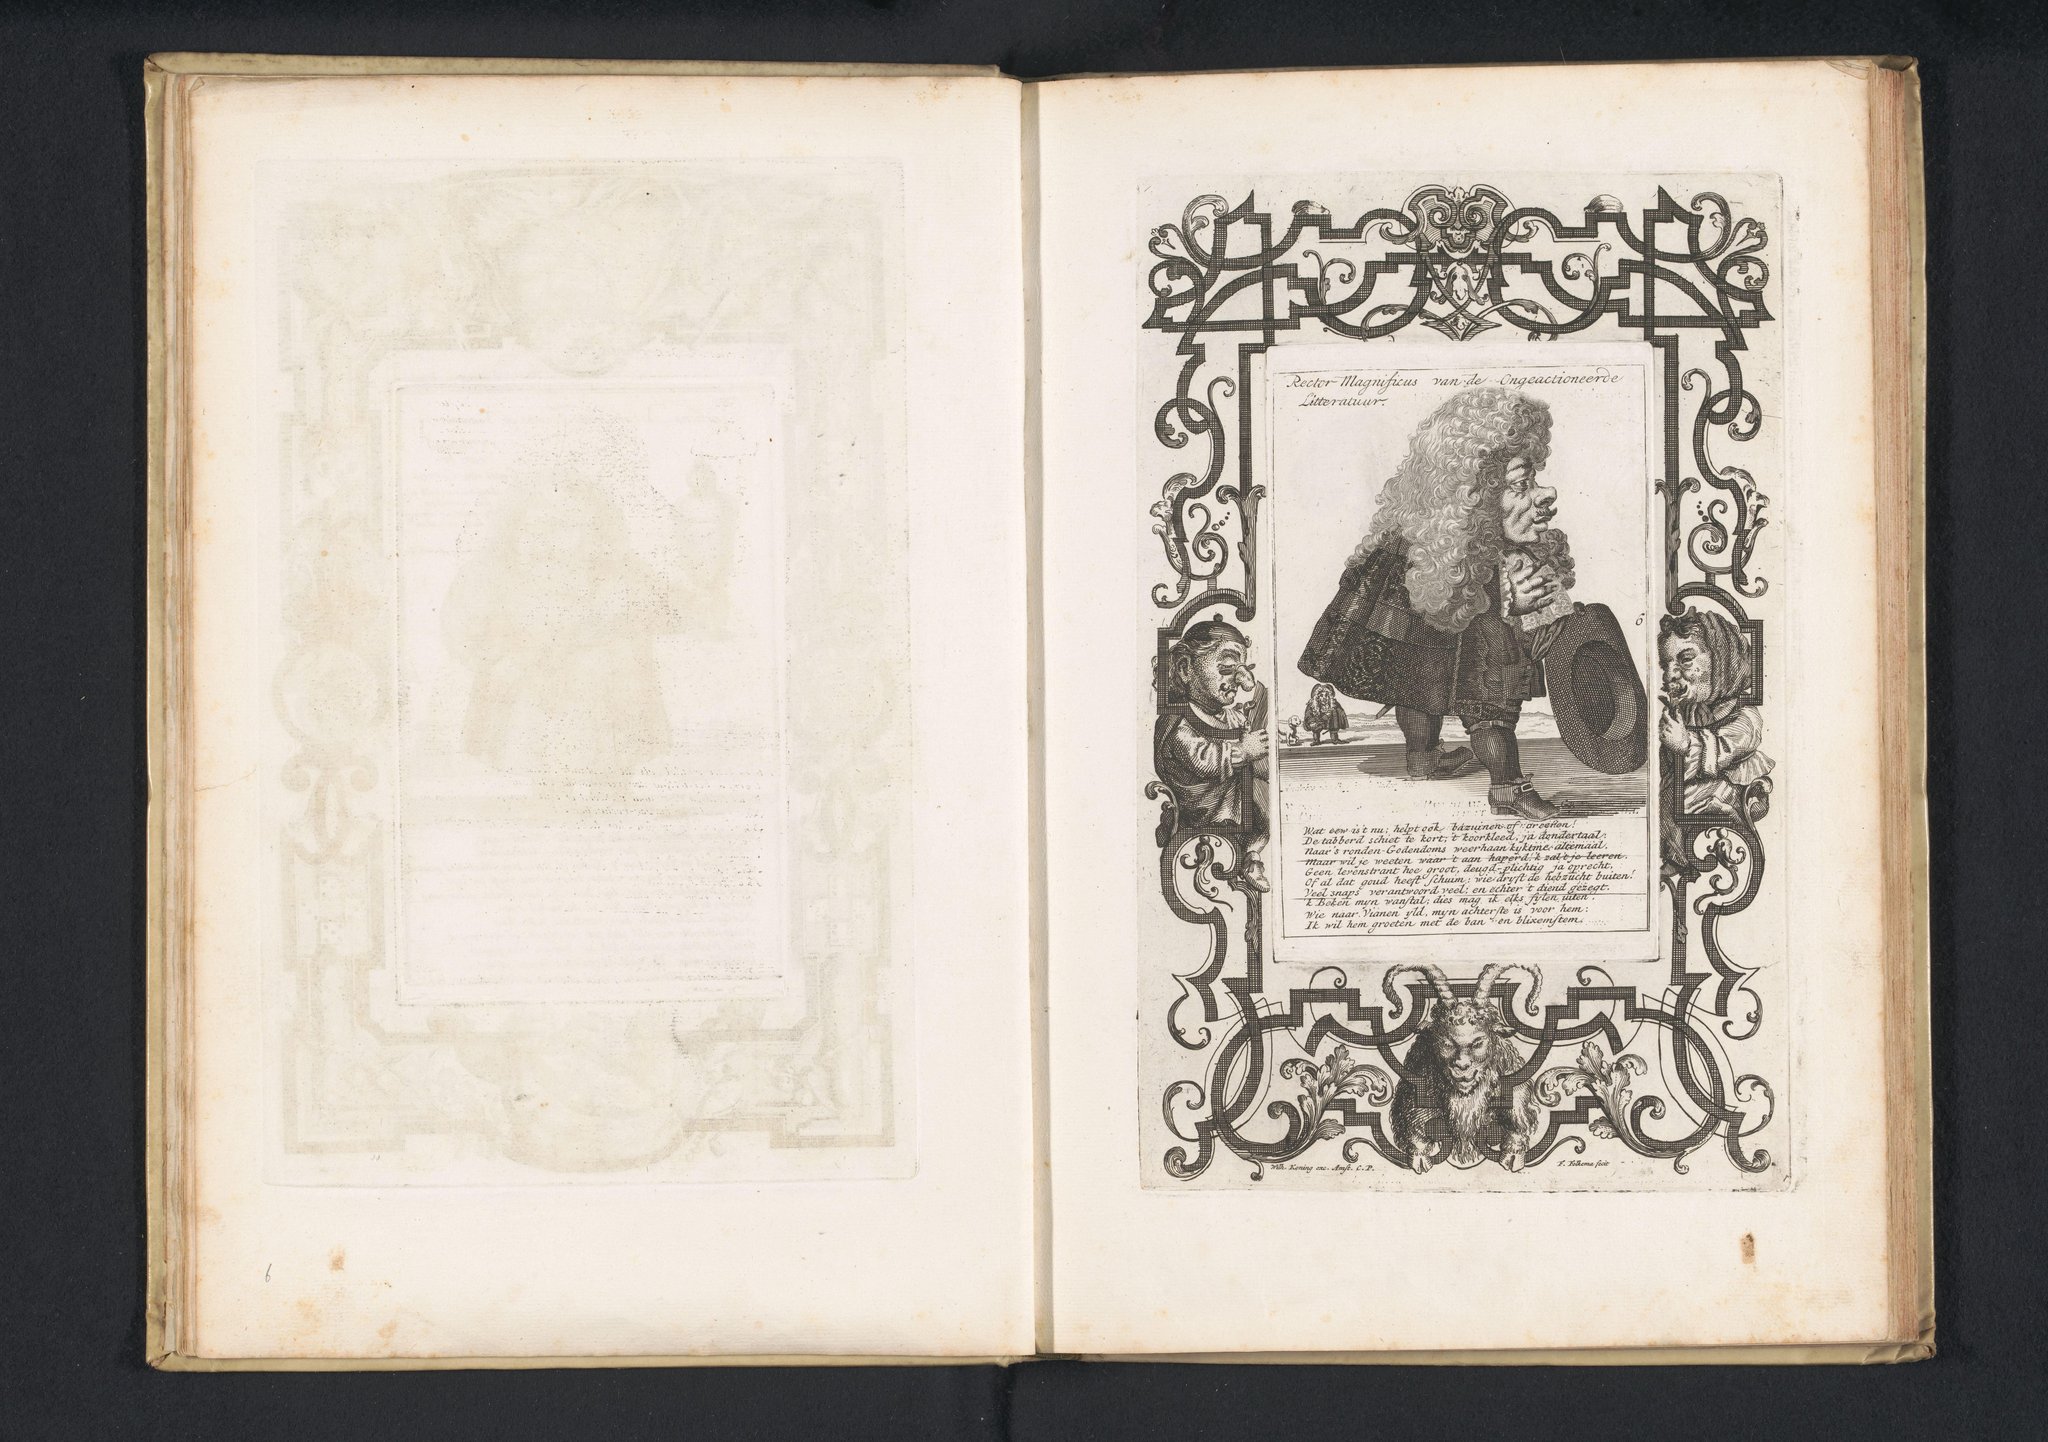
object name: print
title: Dwerg met een grote pruik, de hoed in de hand, 1720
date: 1716-1720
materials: paper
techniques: etching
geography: northern netherlands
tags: caricatures (human types), little people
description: Een kleine mens met een grote pruik, de hoed in de hand. In het onderschrift een vers in het Nederlands. Genummerd rechts midden: 6. Afdruk binnen een decoratieve omlijsting gedrukt van een aparte plaat met kleine mensen, onderaan een bok. Onderdeel van de tweede Nederlandse gebonden uitgave uit 1720 (en gerelateerd aan de Windhandel in dat jaar) van een serie karikaturen van kleine mensen, bekend als Het Dwergentooneel, deels gekopieerd naar een ouder Duits voorbeeld.